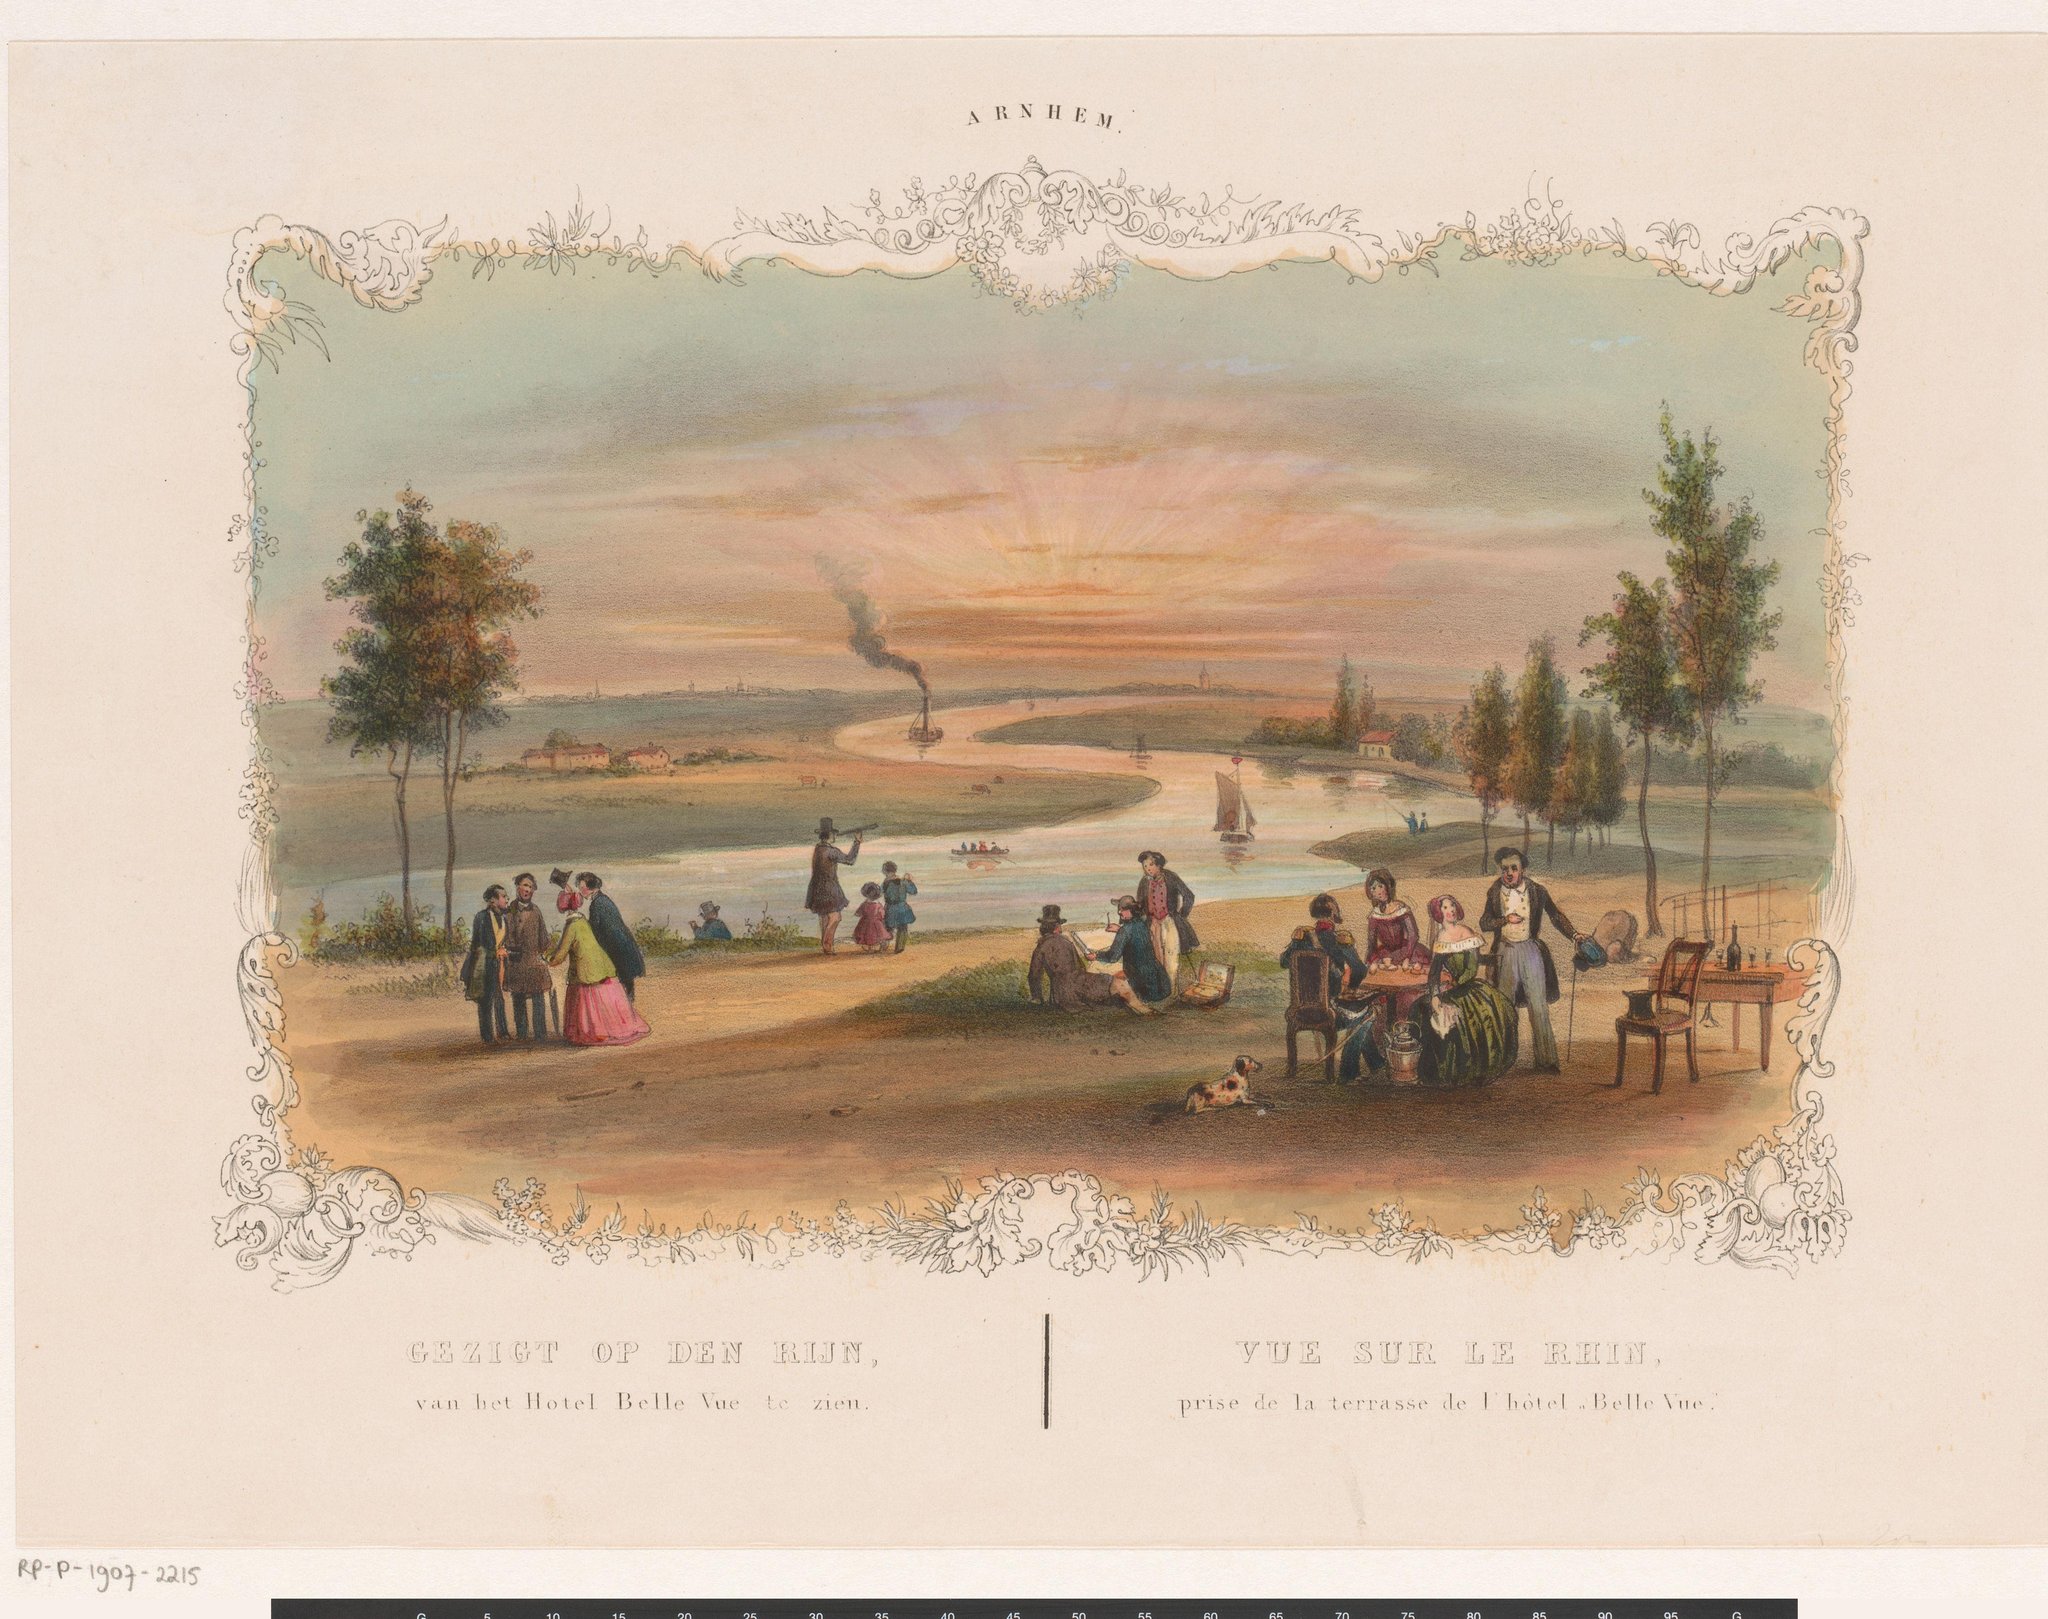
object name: print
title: Arnhem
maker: hendrik wilhelmus last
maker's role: print maker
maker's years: 1817-1873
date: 1827-1873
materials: paper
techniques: hand coloring, lithograph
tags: sailing-ship, sailing-boat, rowing-boat, canoe, etc., sunset, river (+ landscape with figures, staffage), steamship, motorship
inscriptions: collector's mark: Lugt 2228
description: In de voorgrond vermaken gasten van het hotel zich. Op het water varen een roei-, zeil- en stoomboot. Aan de horizon gaat de zon onder.